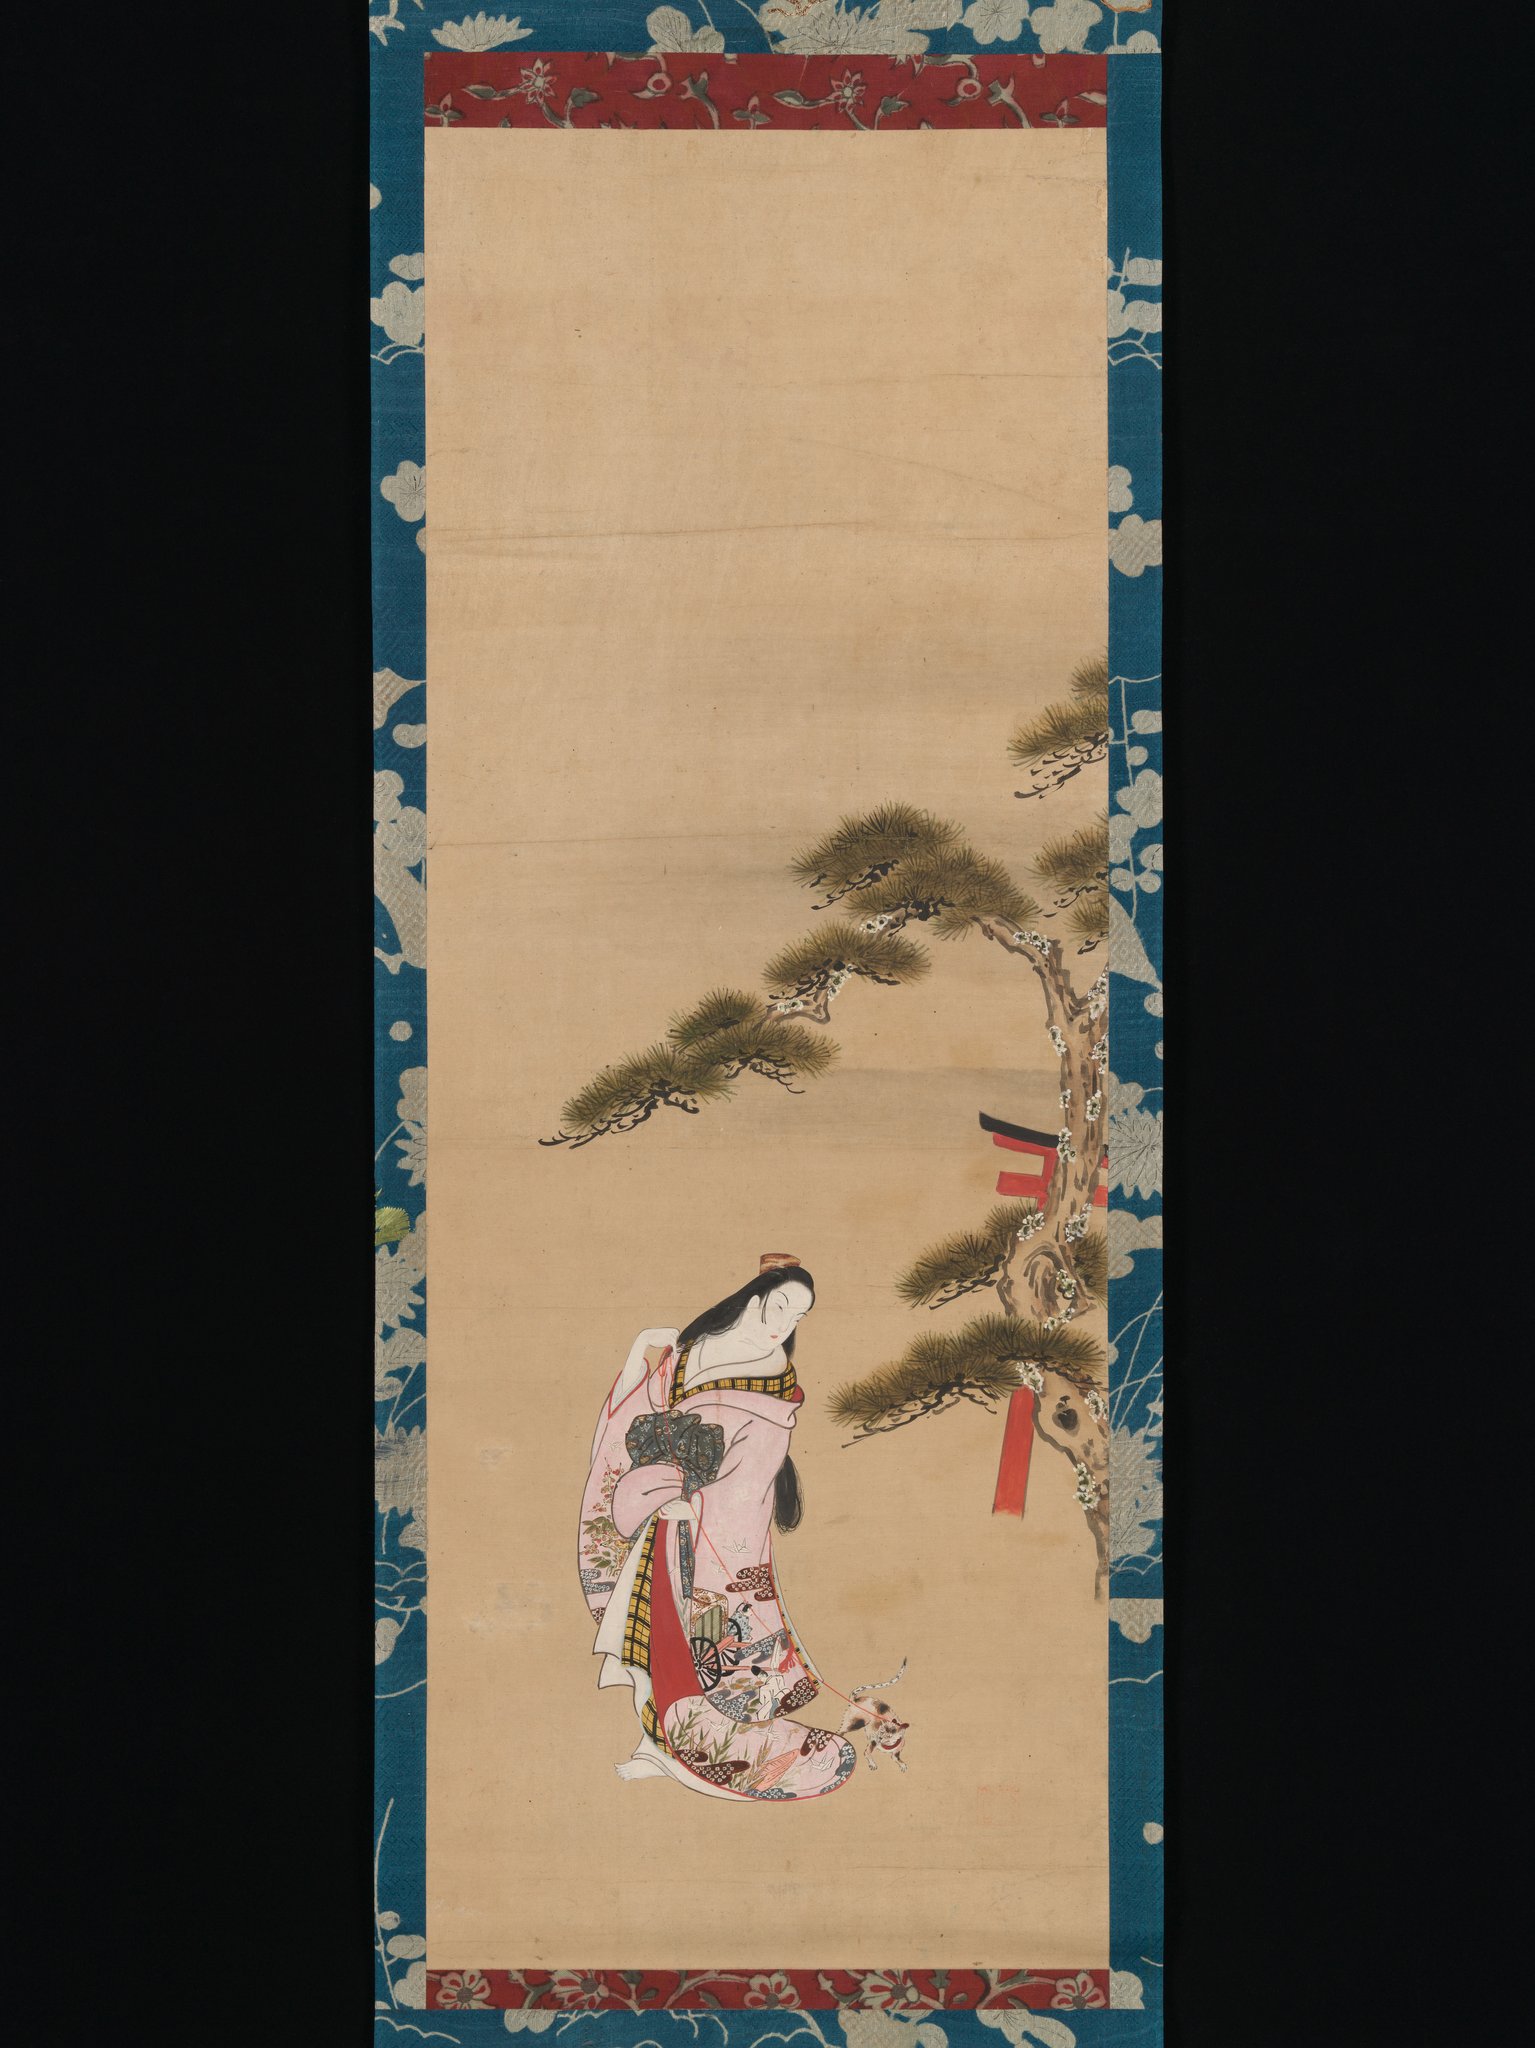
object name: hanging scroll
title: The Third Princess and a Cat, from the "New Herbs I" (Wakana I) chapter The Tale of Genji (Genji monogatari}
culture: japanese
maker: matsuno chikanobu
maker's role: artist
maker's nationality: japanese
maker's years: 1700-1733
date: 1701-1800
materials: ink, paper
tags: princesses,women,cats